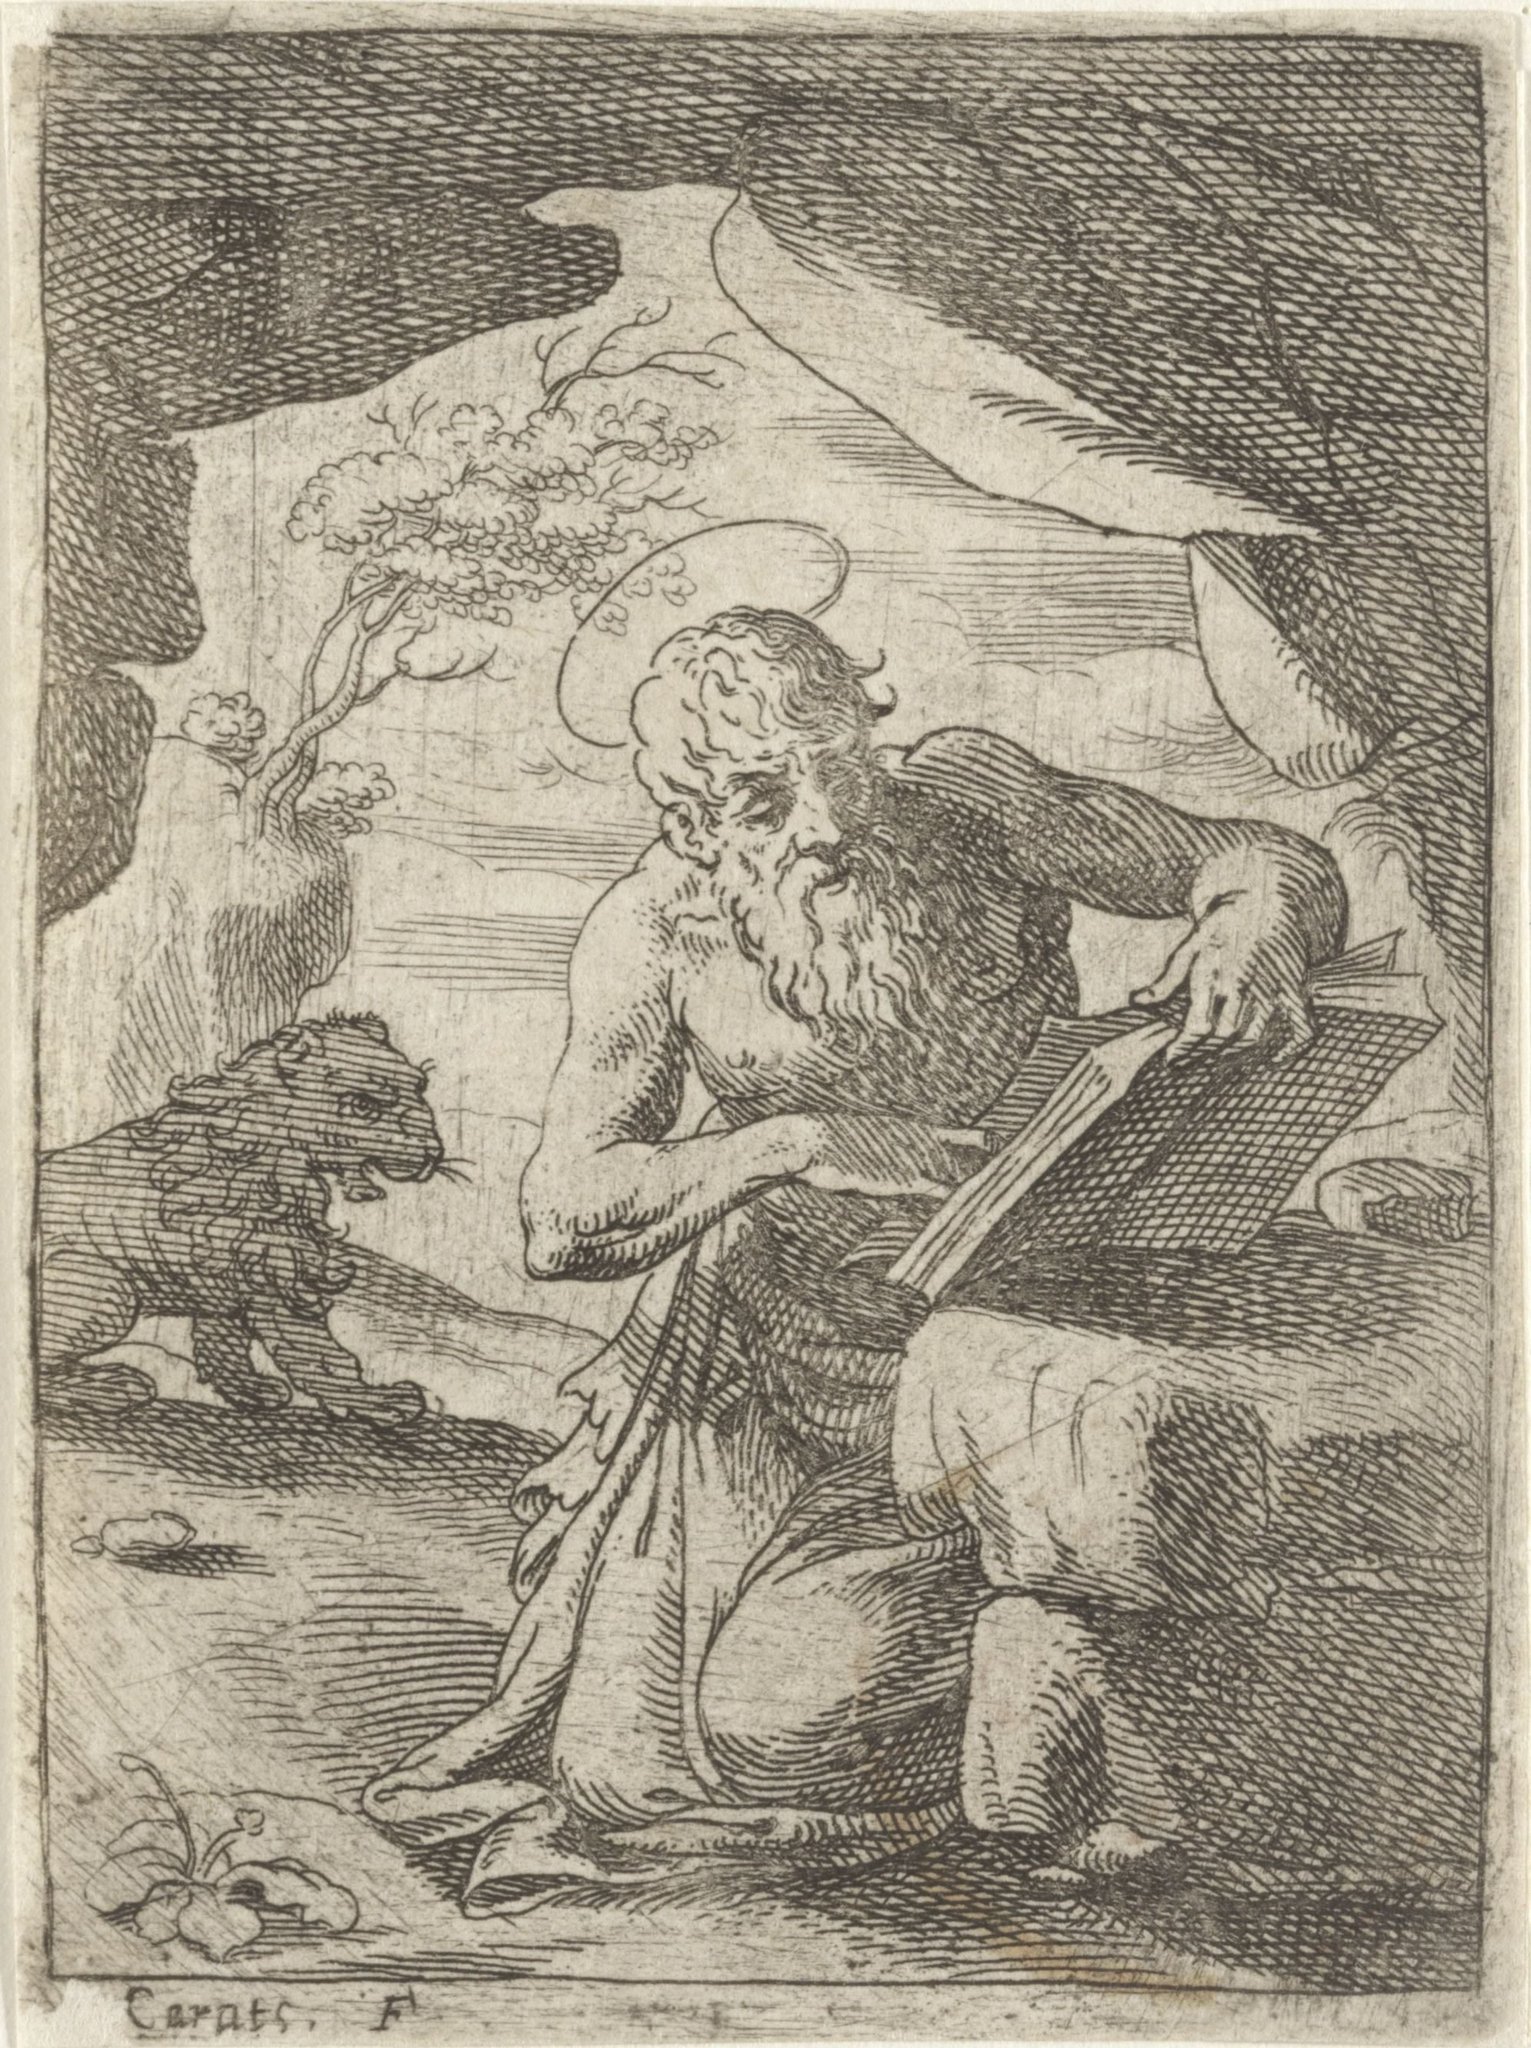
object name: print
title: De heilige Hieronymus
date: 1570-1609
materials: paper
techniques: etching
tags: the monk and hermit jerome (hieronymus); possible attributes: book, cardinal's hat, crucifix, hour-glass, lion, skull, stone, cave, grotto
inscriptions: collector's mark: Lugt 240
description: De heilige Hieronymus zit geknield in een grot en kijkt in een boek. Op de achtergrond een leeuw.